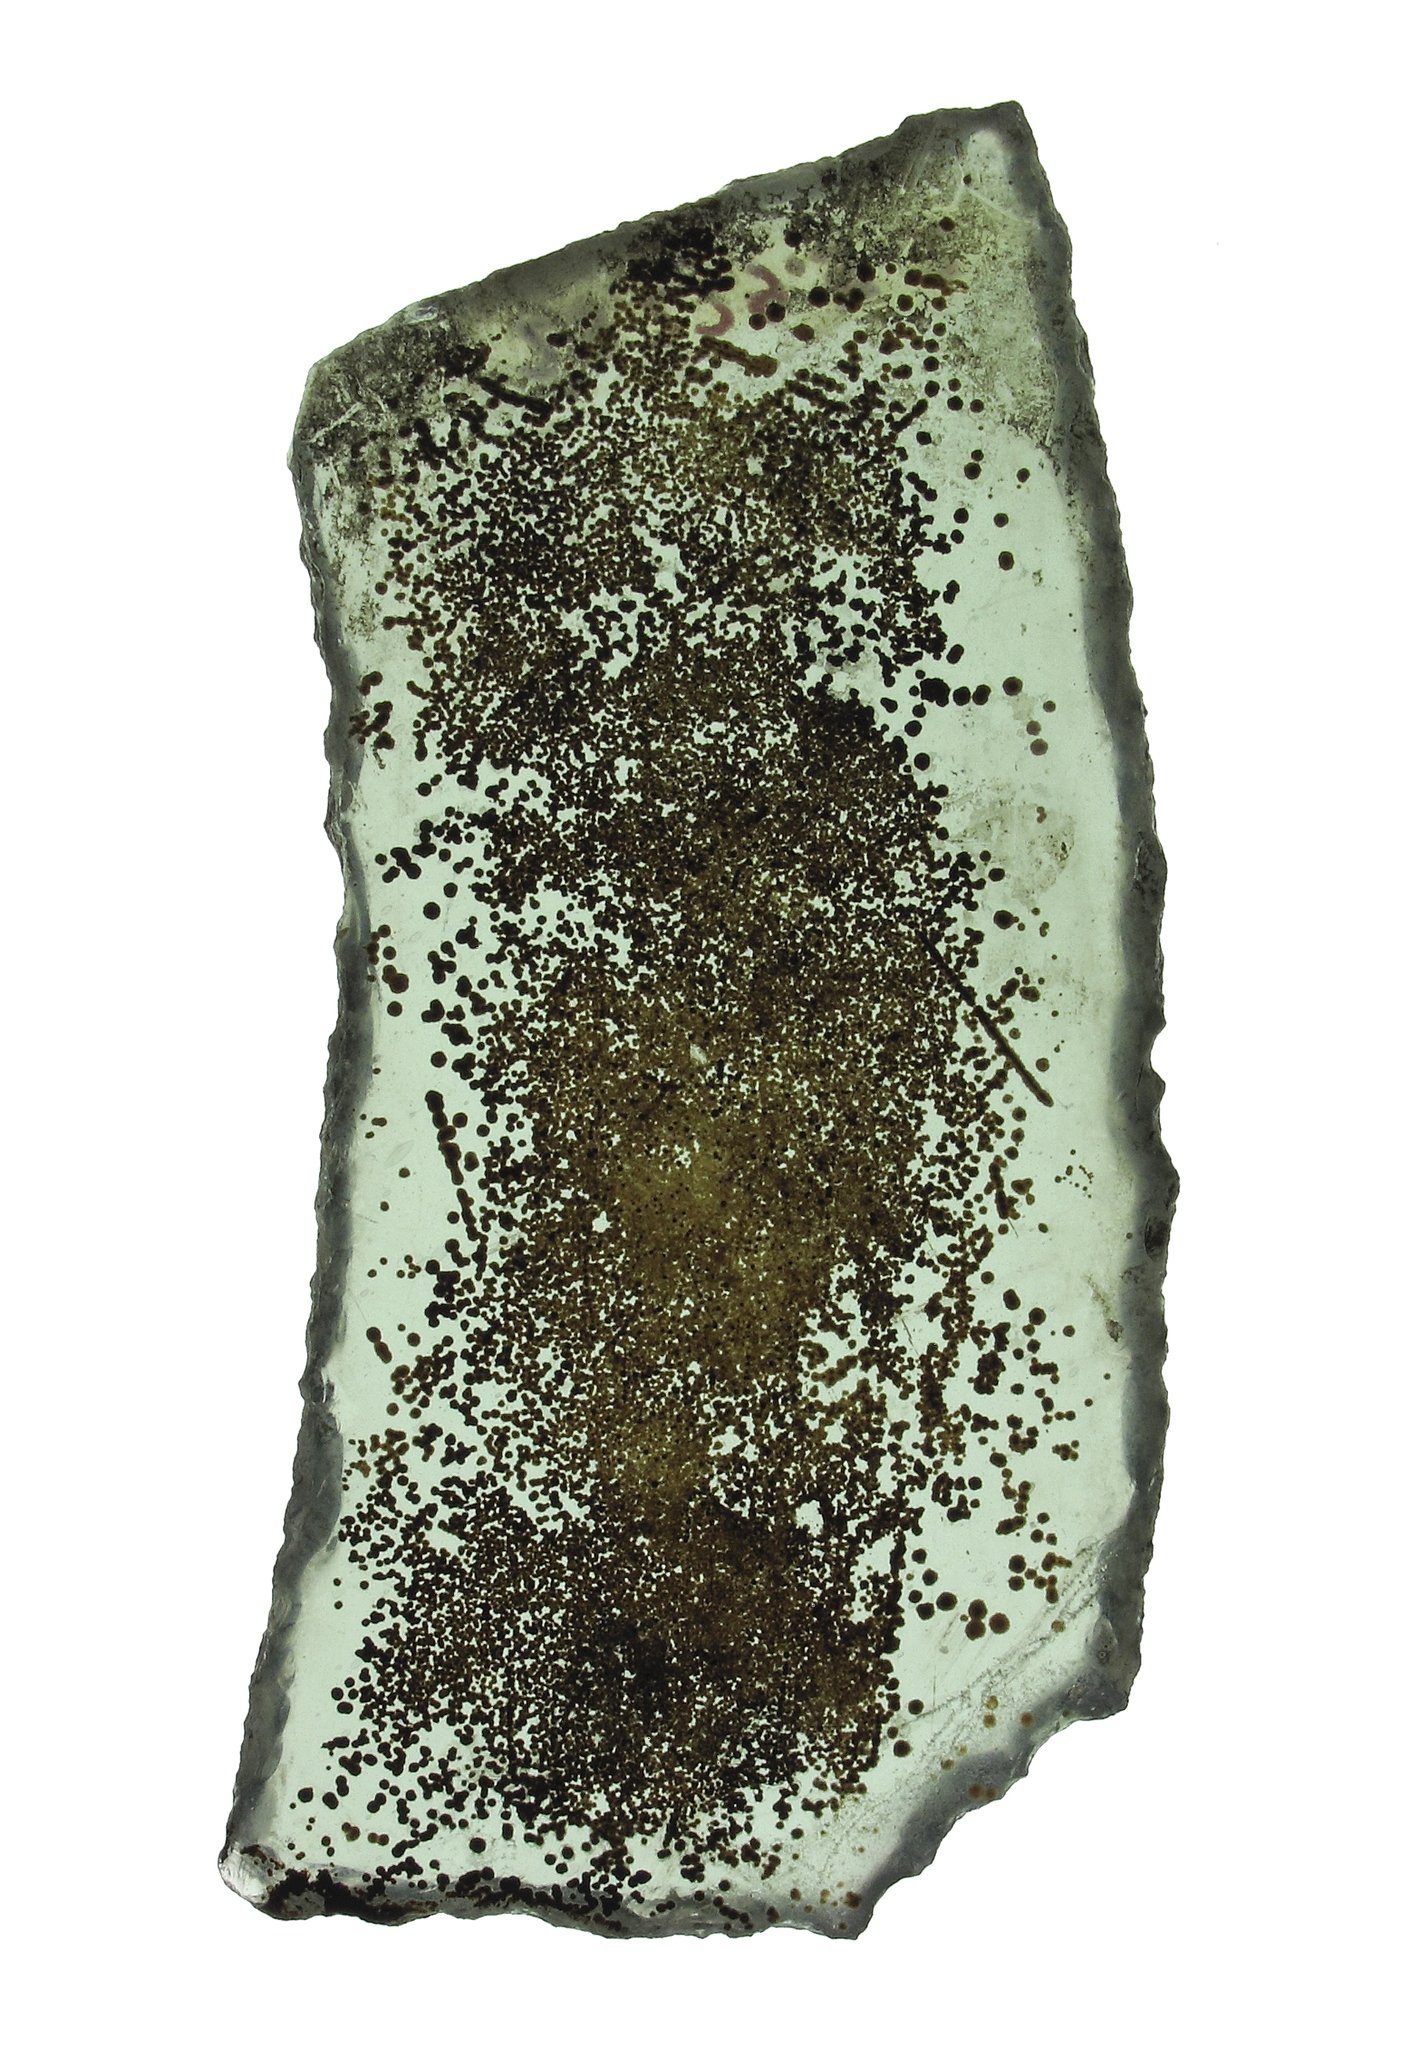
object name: fragment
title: Glass Fragment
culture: french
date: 1101-1200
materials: glass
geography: france